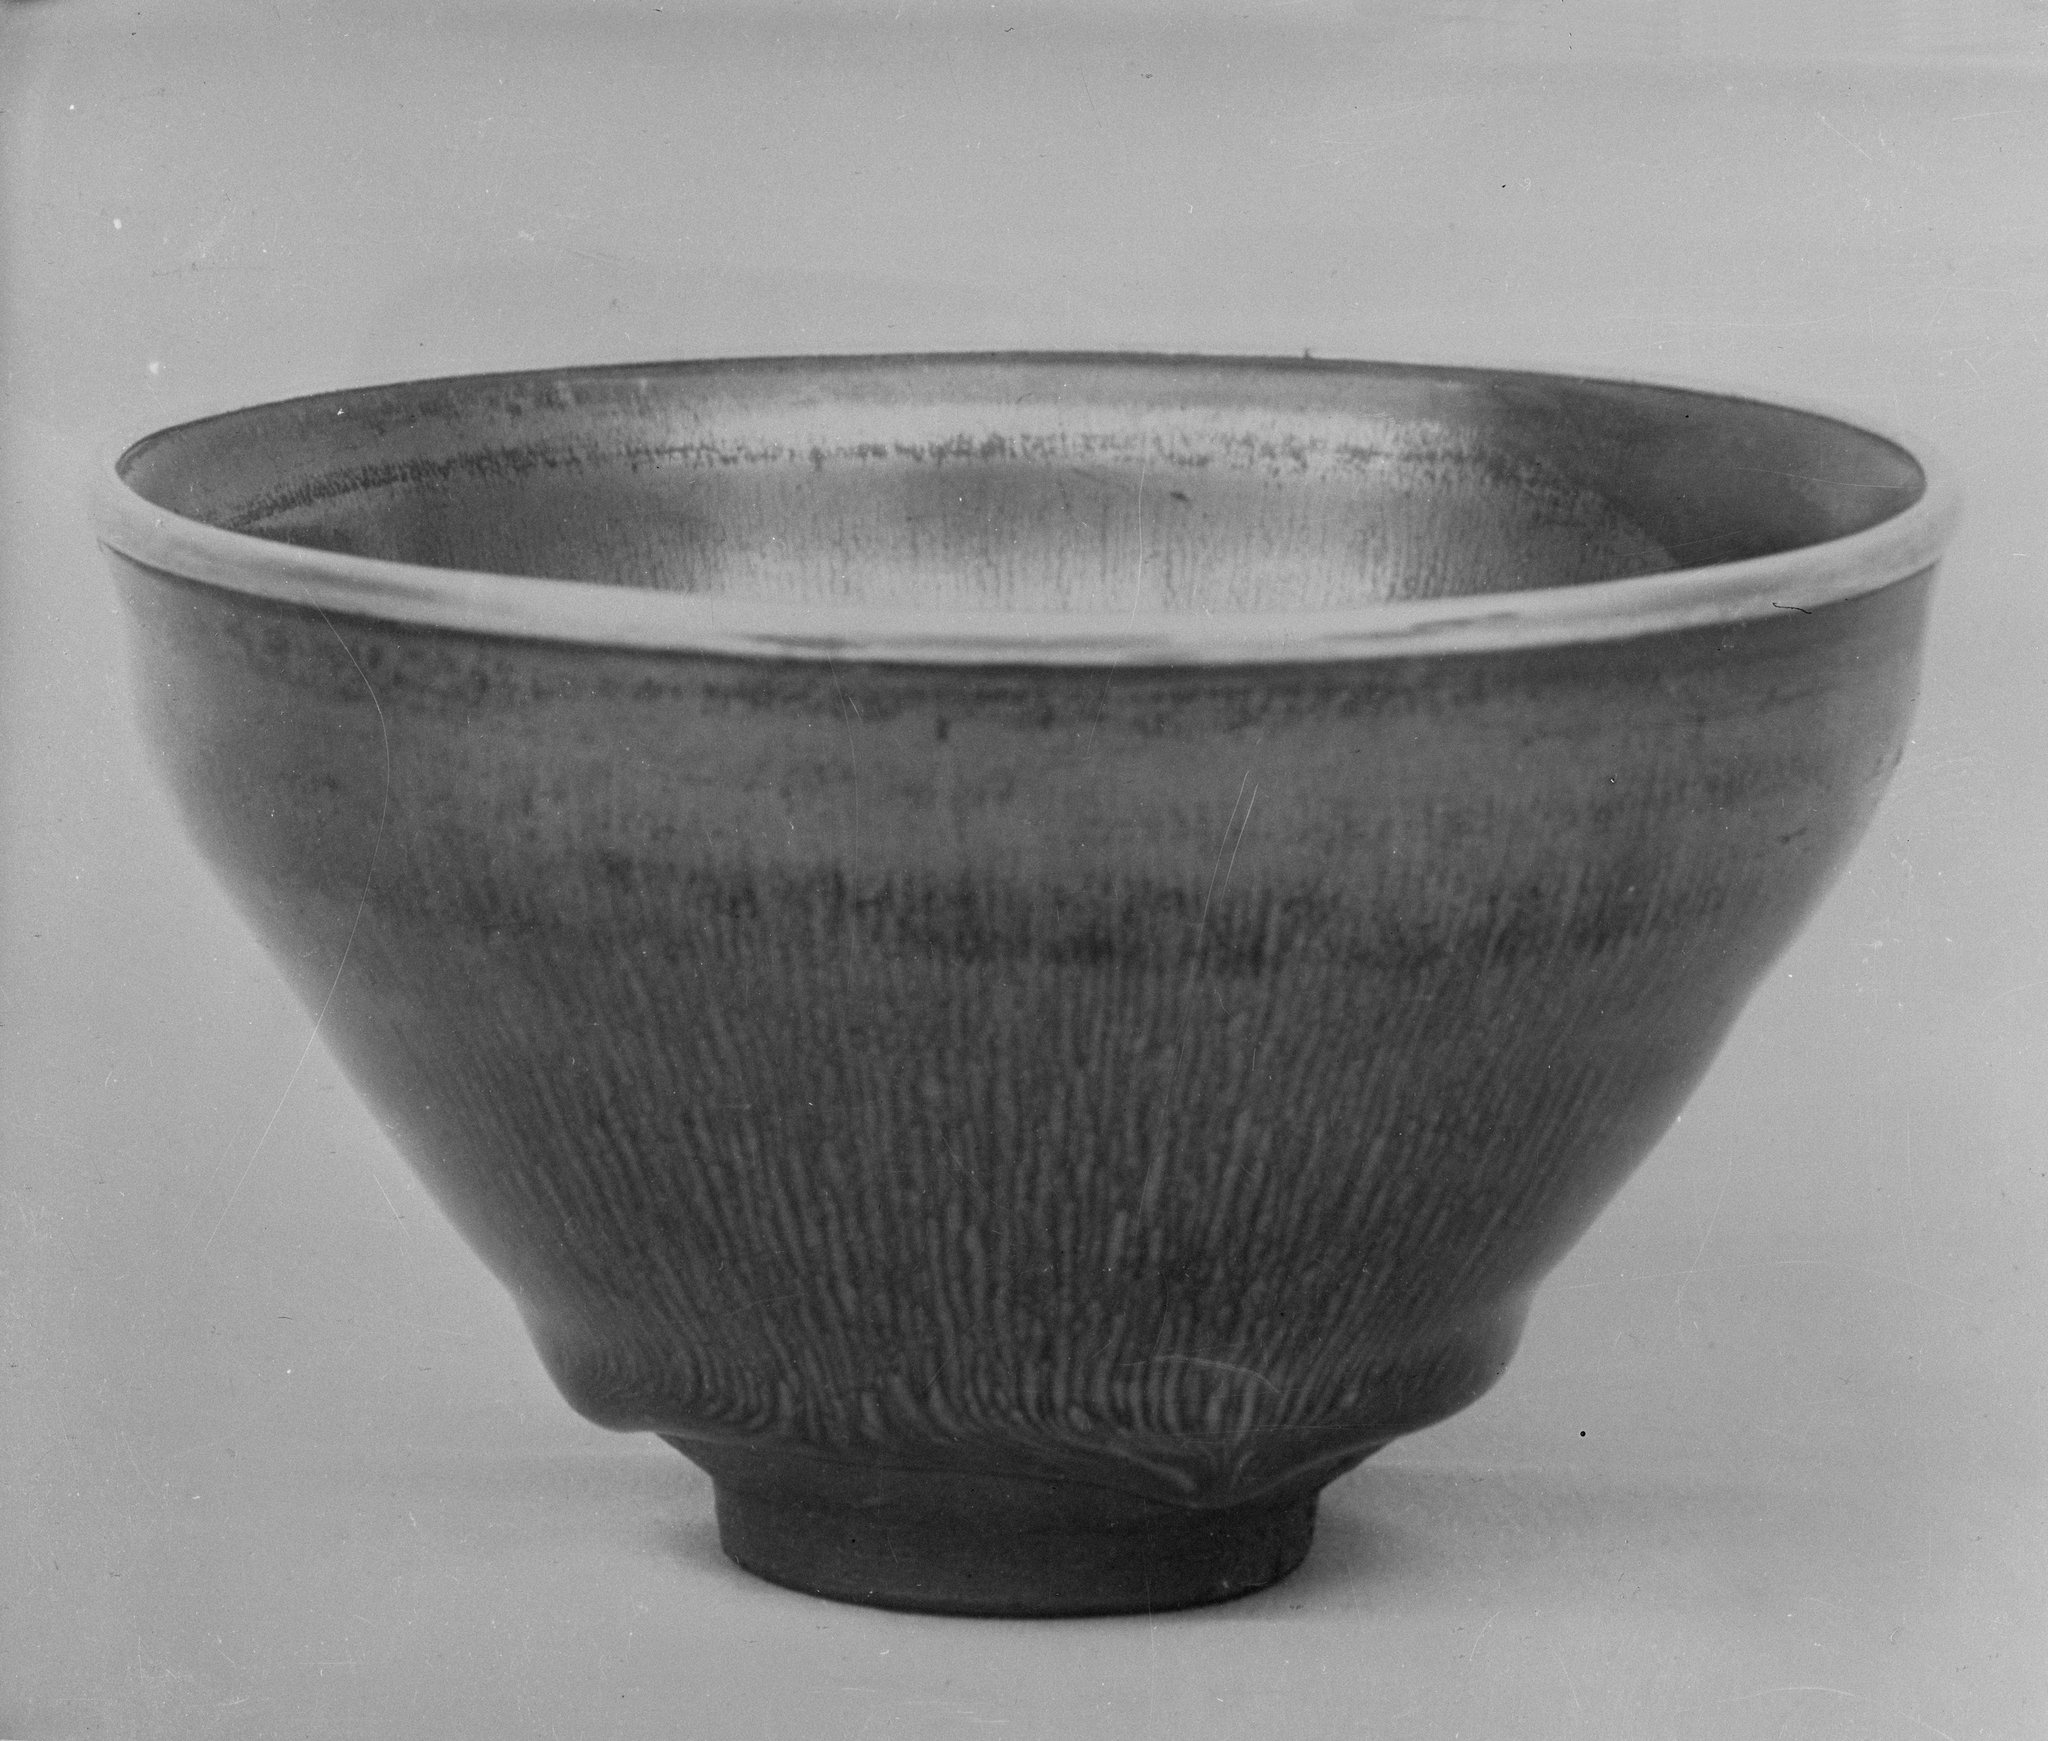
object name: bowl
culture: chinese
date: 960-1279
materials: glaze, gold